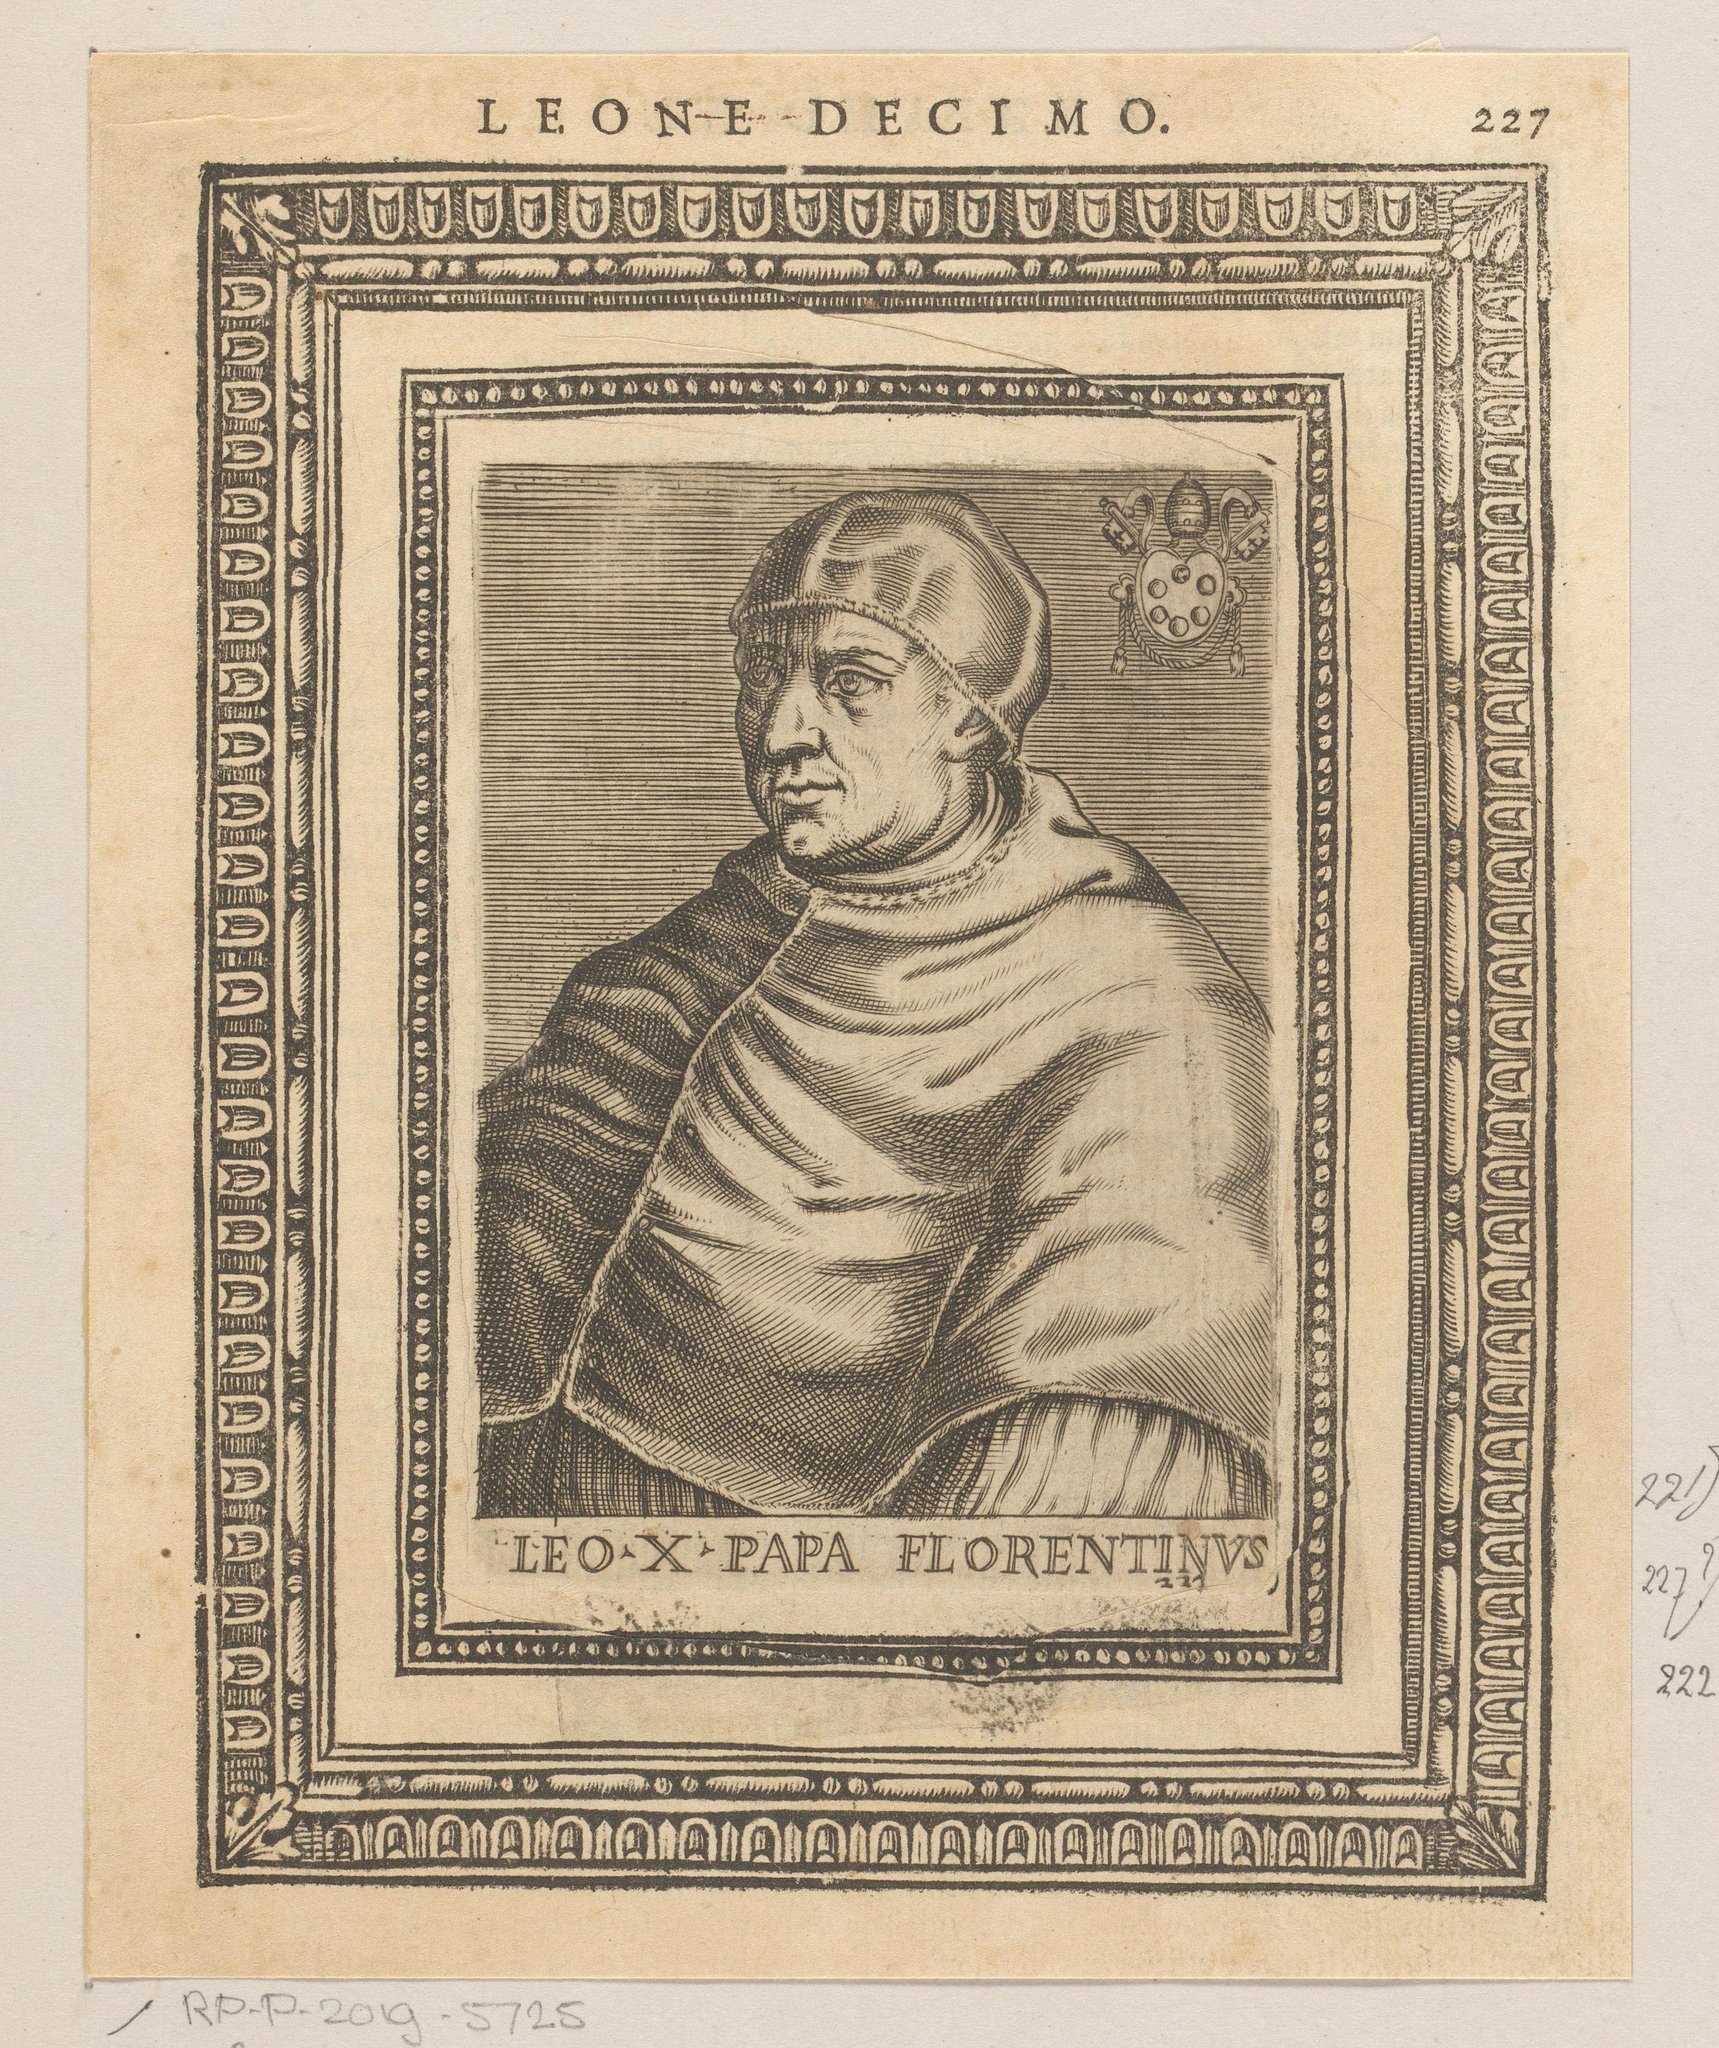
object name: book illustration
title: Portret van paus Leo X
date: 1587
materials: paper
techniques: engraving, letterpress printing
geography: rome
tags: leo x, historical persons, pope, armorial bearing, heraldry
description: Prent uit: Ciccarelli, Antonio. Le vite de Pontefici di Antonio Ciccarelli (...). Rome: Domenico Basa, 1587. Prent voor het eerst verschenen in: Cavalieri, Giovanni Battista de'. Pontificum romanorum effigies (...). Rome: Domenico Basa en Francesco Zanetti, 1580. Prent ook gebruikt in latere publicaties.